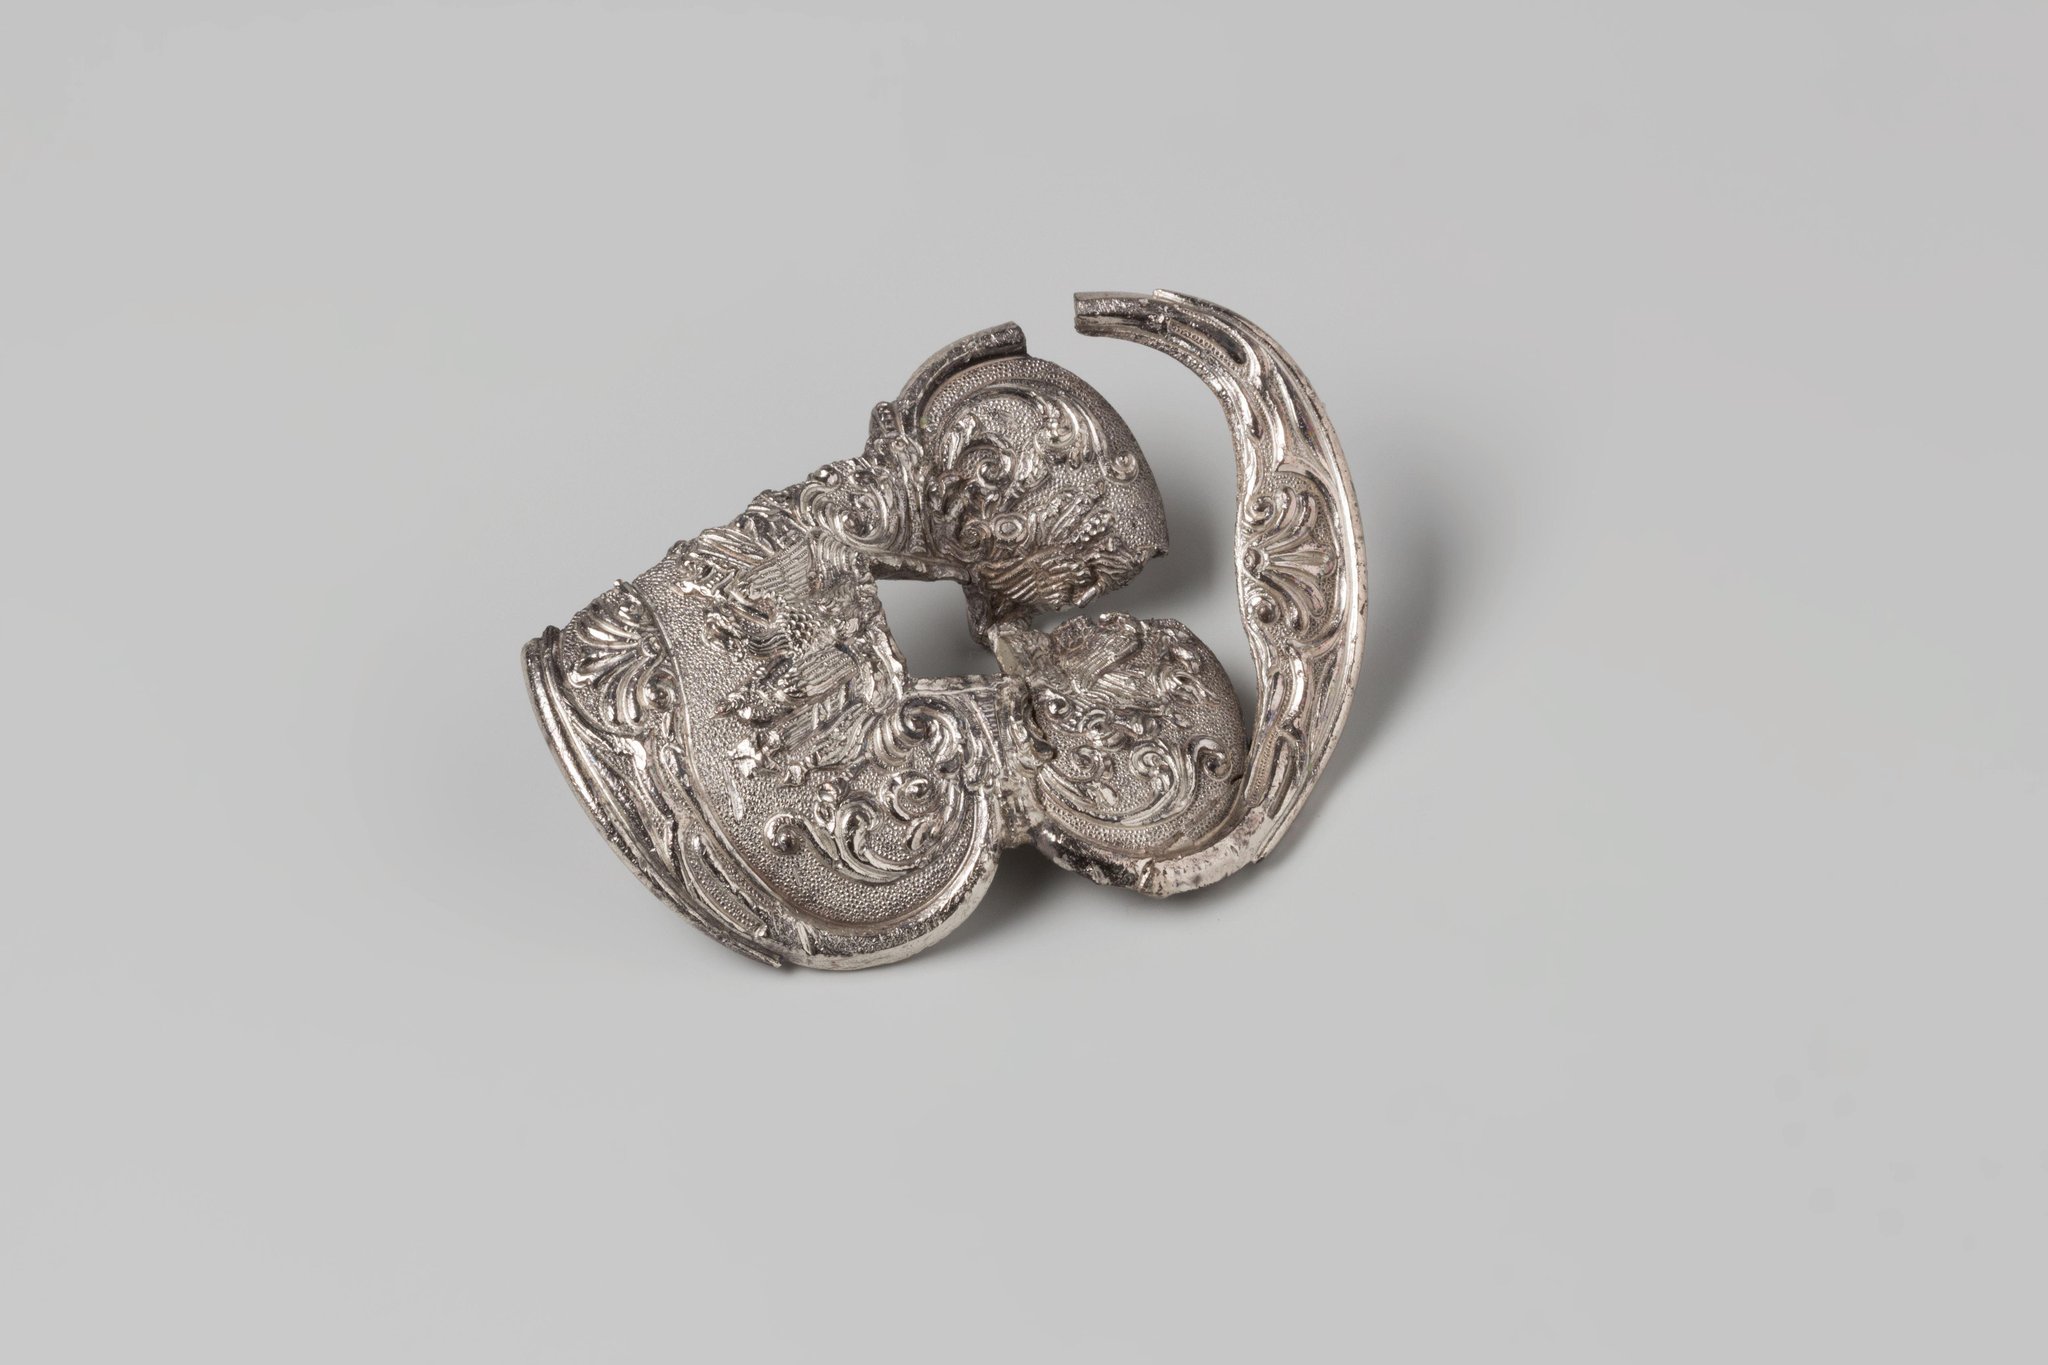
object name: beugel gevestl, gevestbeugel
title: Silver crossbar of a sword from the wreck of the Dutch East Indiaman Hollandia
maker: Anonymous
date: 1700-1743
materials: silver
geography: netherlands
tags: verenigde oostindische compagnie, hollandia (schip), annet